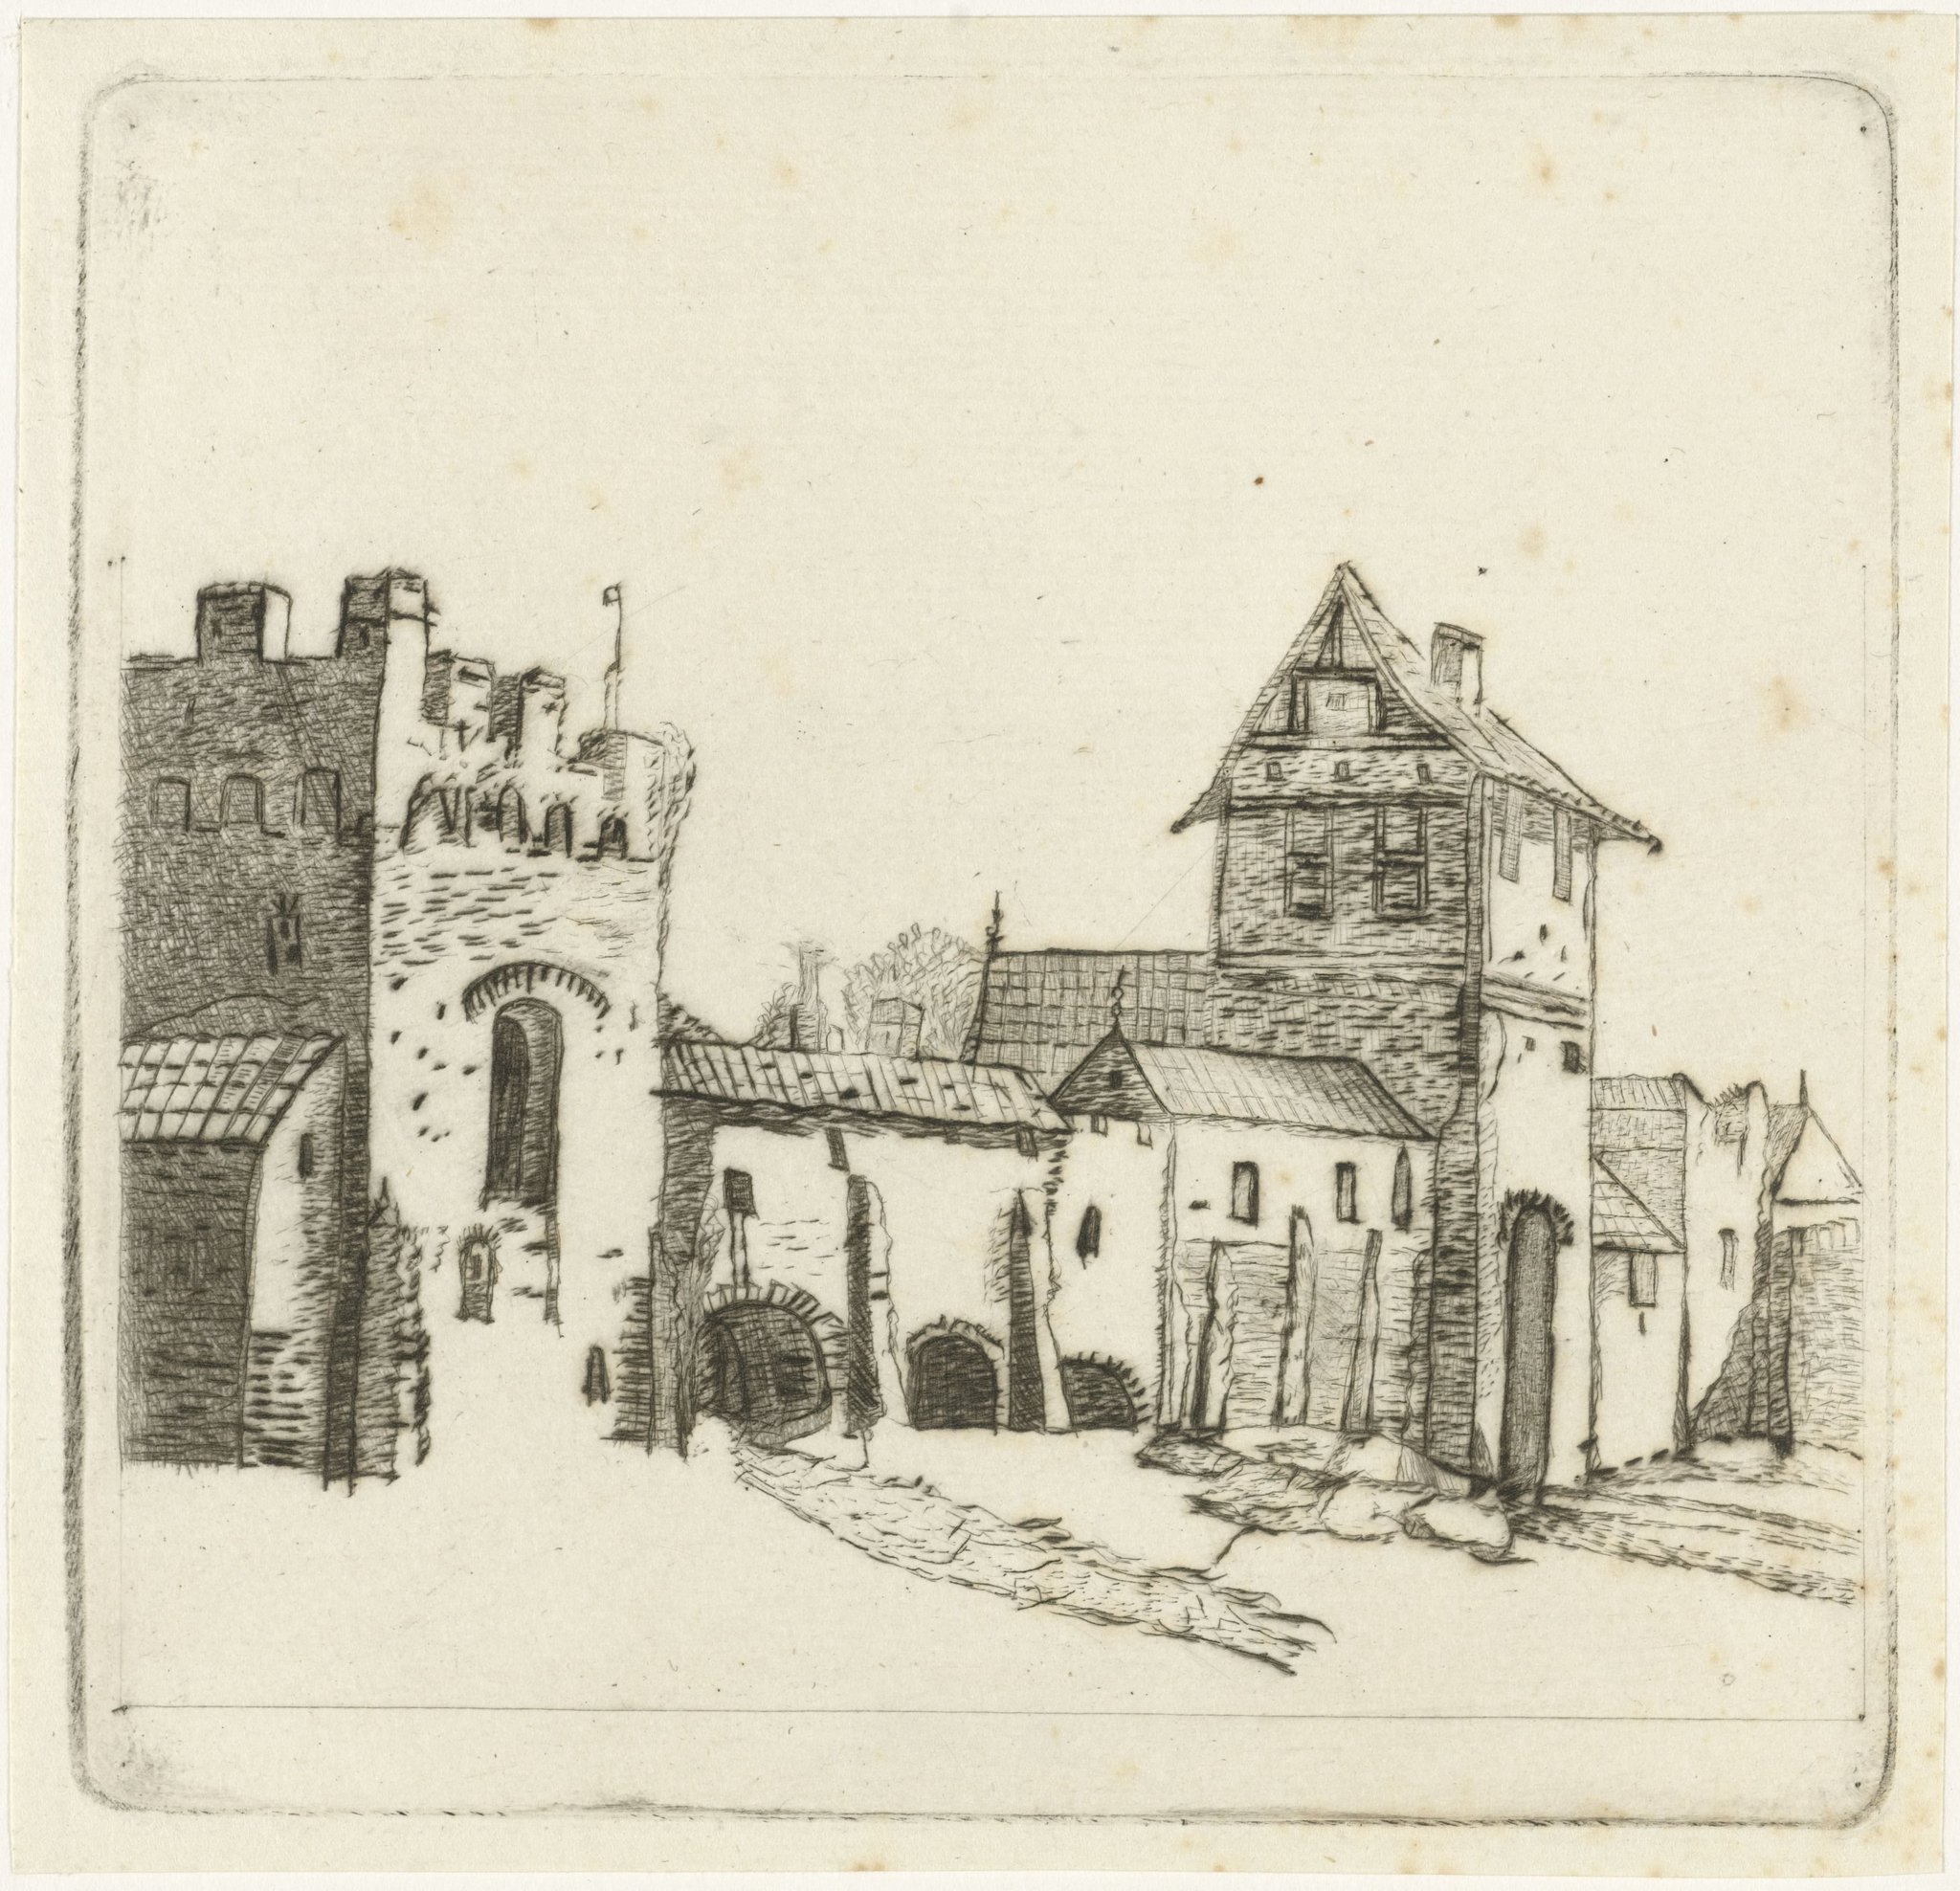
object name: print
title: Stadsmuren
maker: christiaan friedrich ruppe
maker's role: print maker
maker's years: 1753-1826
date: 1763-1826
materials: paper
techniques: drypoint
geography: europe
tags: city-walls